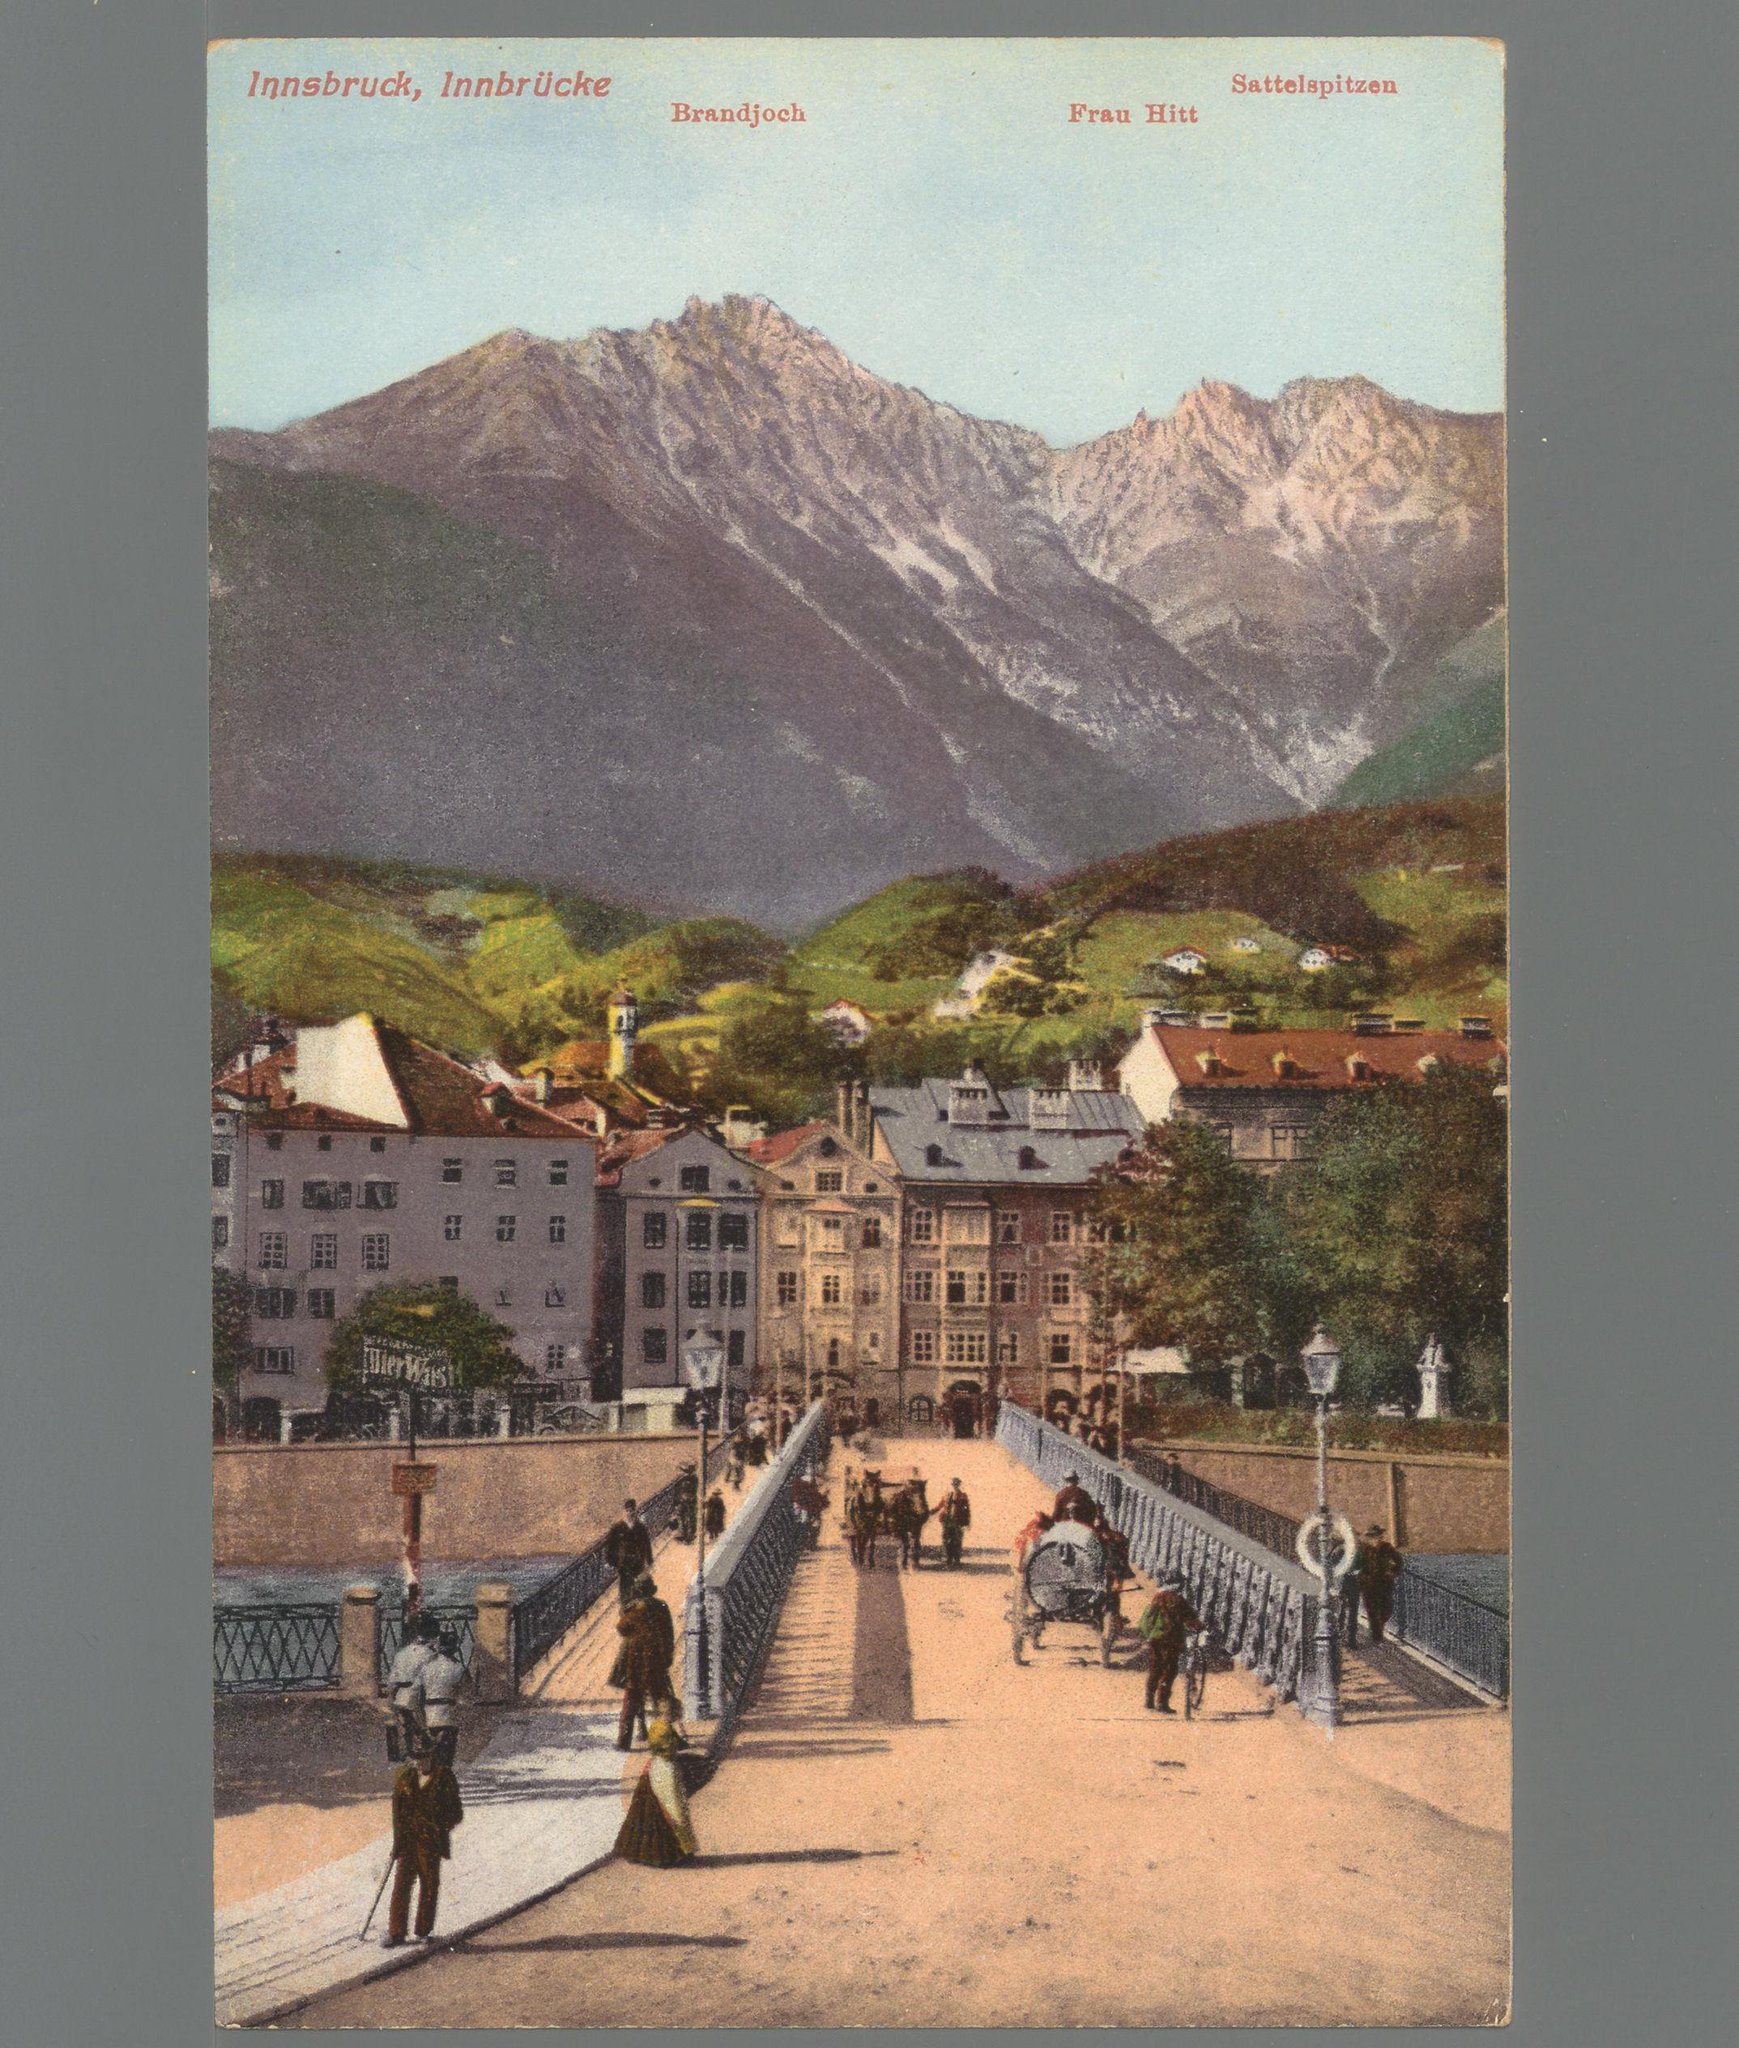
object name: ansichtkaart, prentbriefkaart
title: Innsbruck, Innbrücke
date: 1904-1930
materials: cardboard, photographic process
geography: innsbruck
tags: city-view, and landscape with man-made constructions, bridge in city across river, canal, etc., mountains